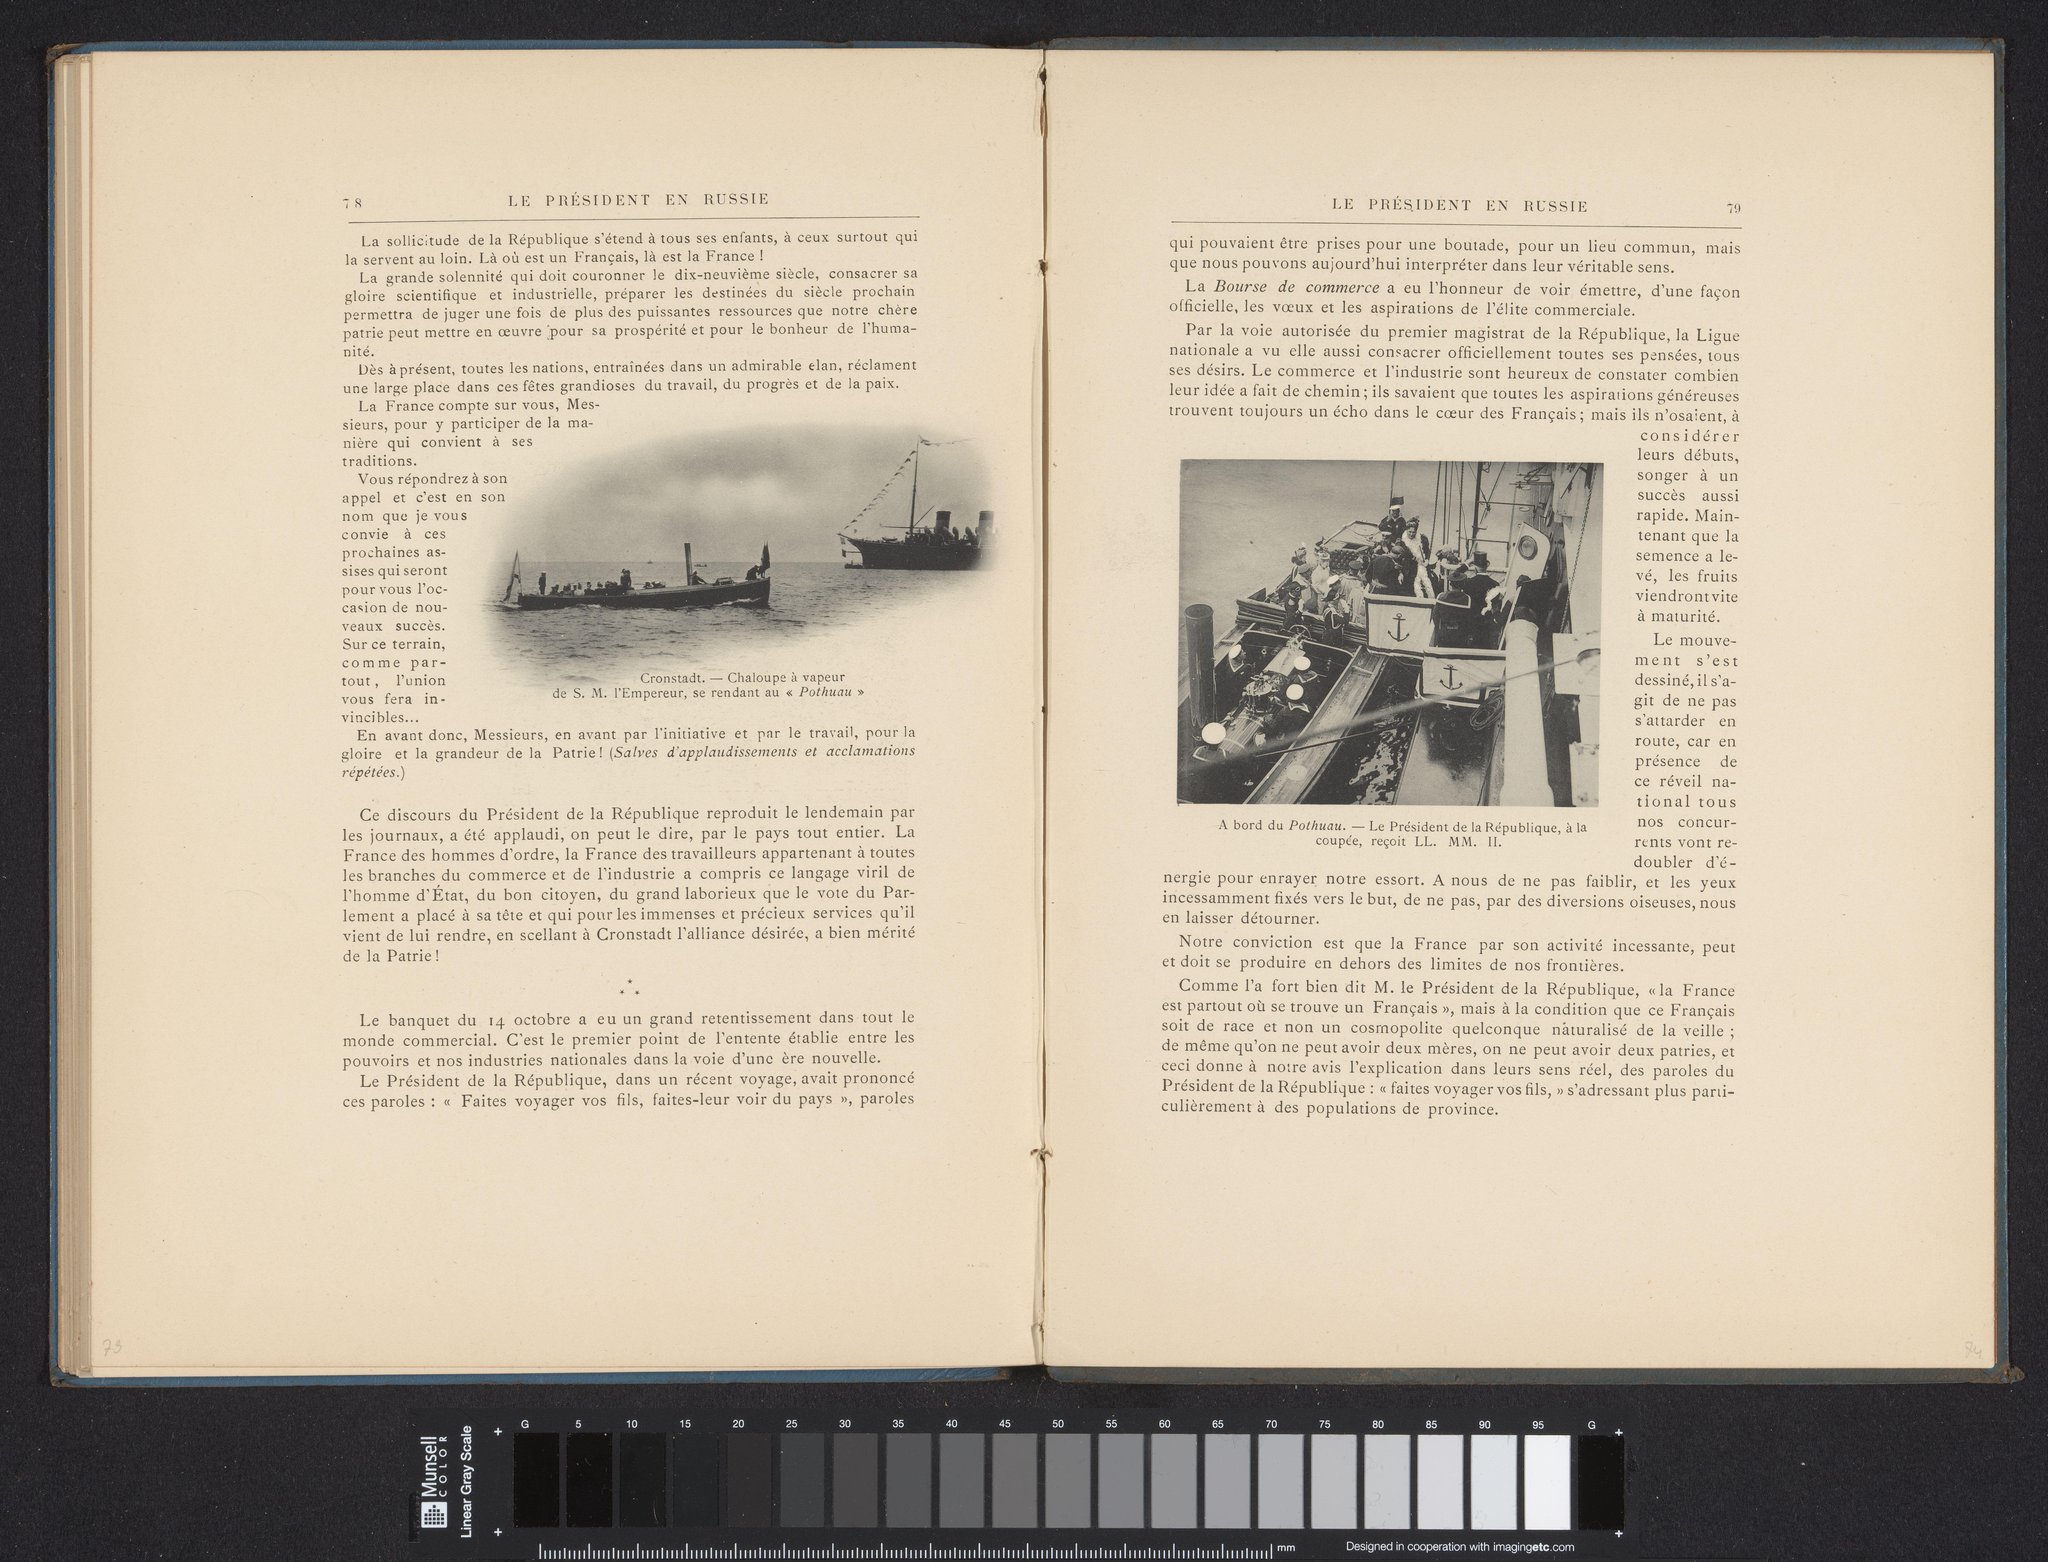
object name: page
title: President Félix Faure ontvangt tsaar Nicolaas II van Rusland en tsarina Alexandra Fjodorovna aan boord van de kruiser Pothuau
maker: Anonymous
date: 1897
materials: paper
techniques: photograph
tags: paris, ruler, sovereign - bb - female ruler, ships (in general), ruler, sovereign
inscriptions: inscription: ‘A bord de Pothuau. (...) LL. MM. II.’